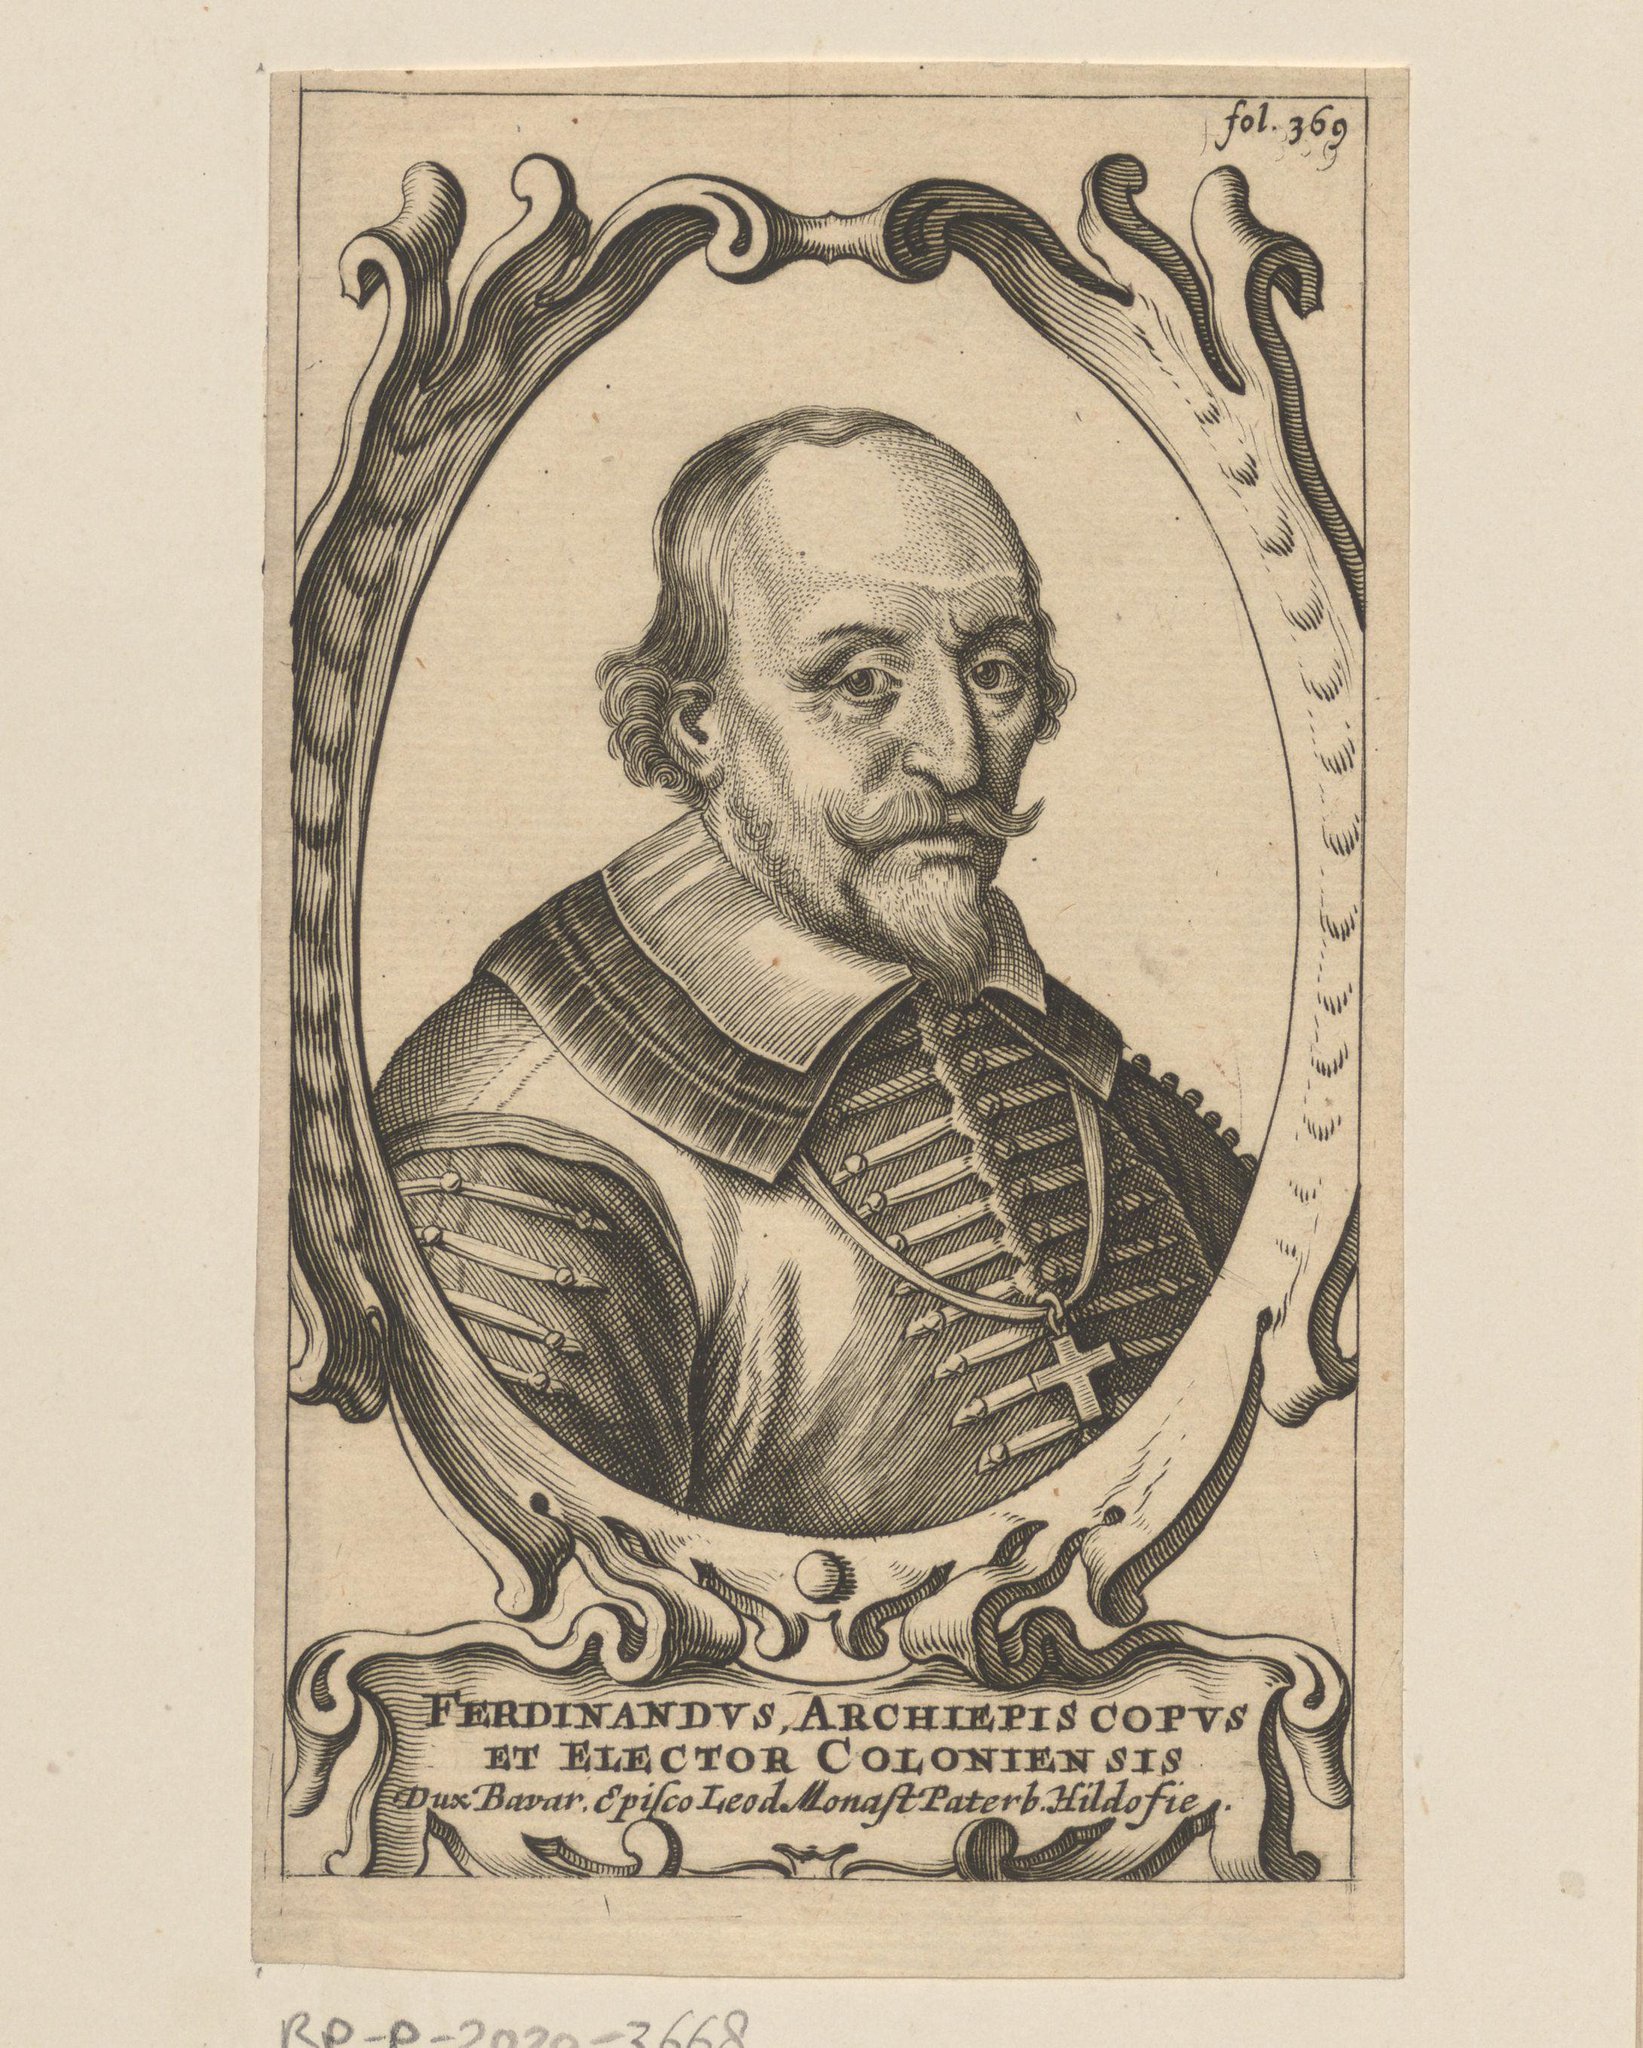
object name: print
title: Portret van Ferdinand van Beieren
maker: Anonymous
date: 1656-1666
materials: paper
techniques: engraving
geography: northern netherlands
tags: ferdinand van beieren, historical persons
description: Prent waarschijnlijk uit: Brachelius, Johannes Adolphus. Historia nostri temporis, dat is geschiedenis onses tijts (…). Rotterdam: Andries van Hoogenhuysen, 1656. Prent ook gebruikt in de 1659- en 1666-editie.